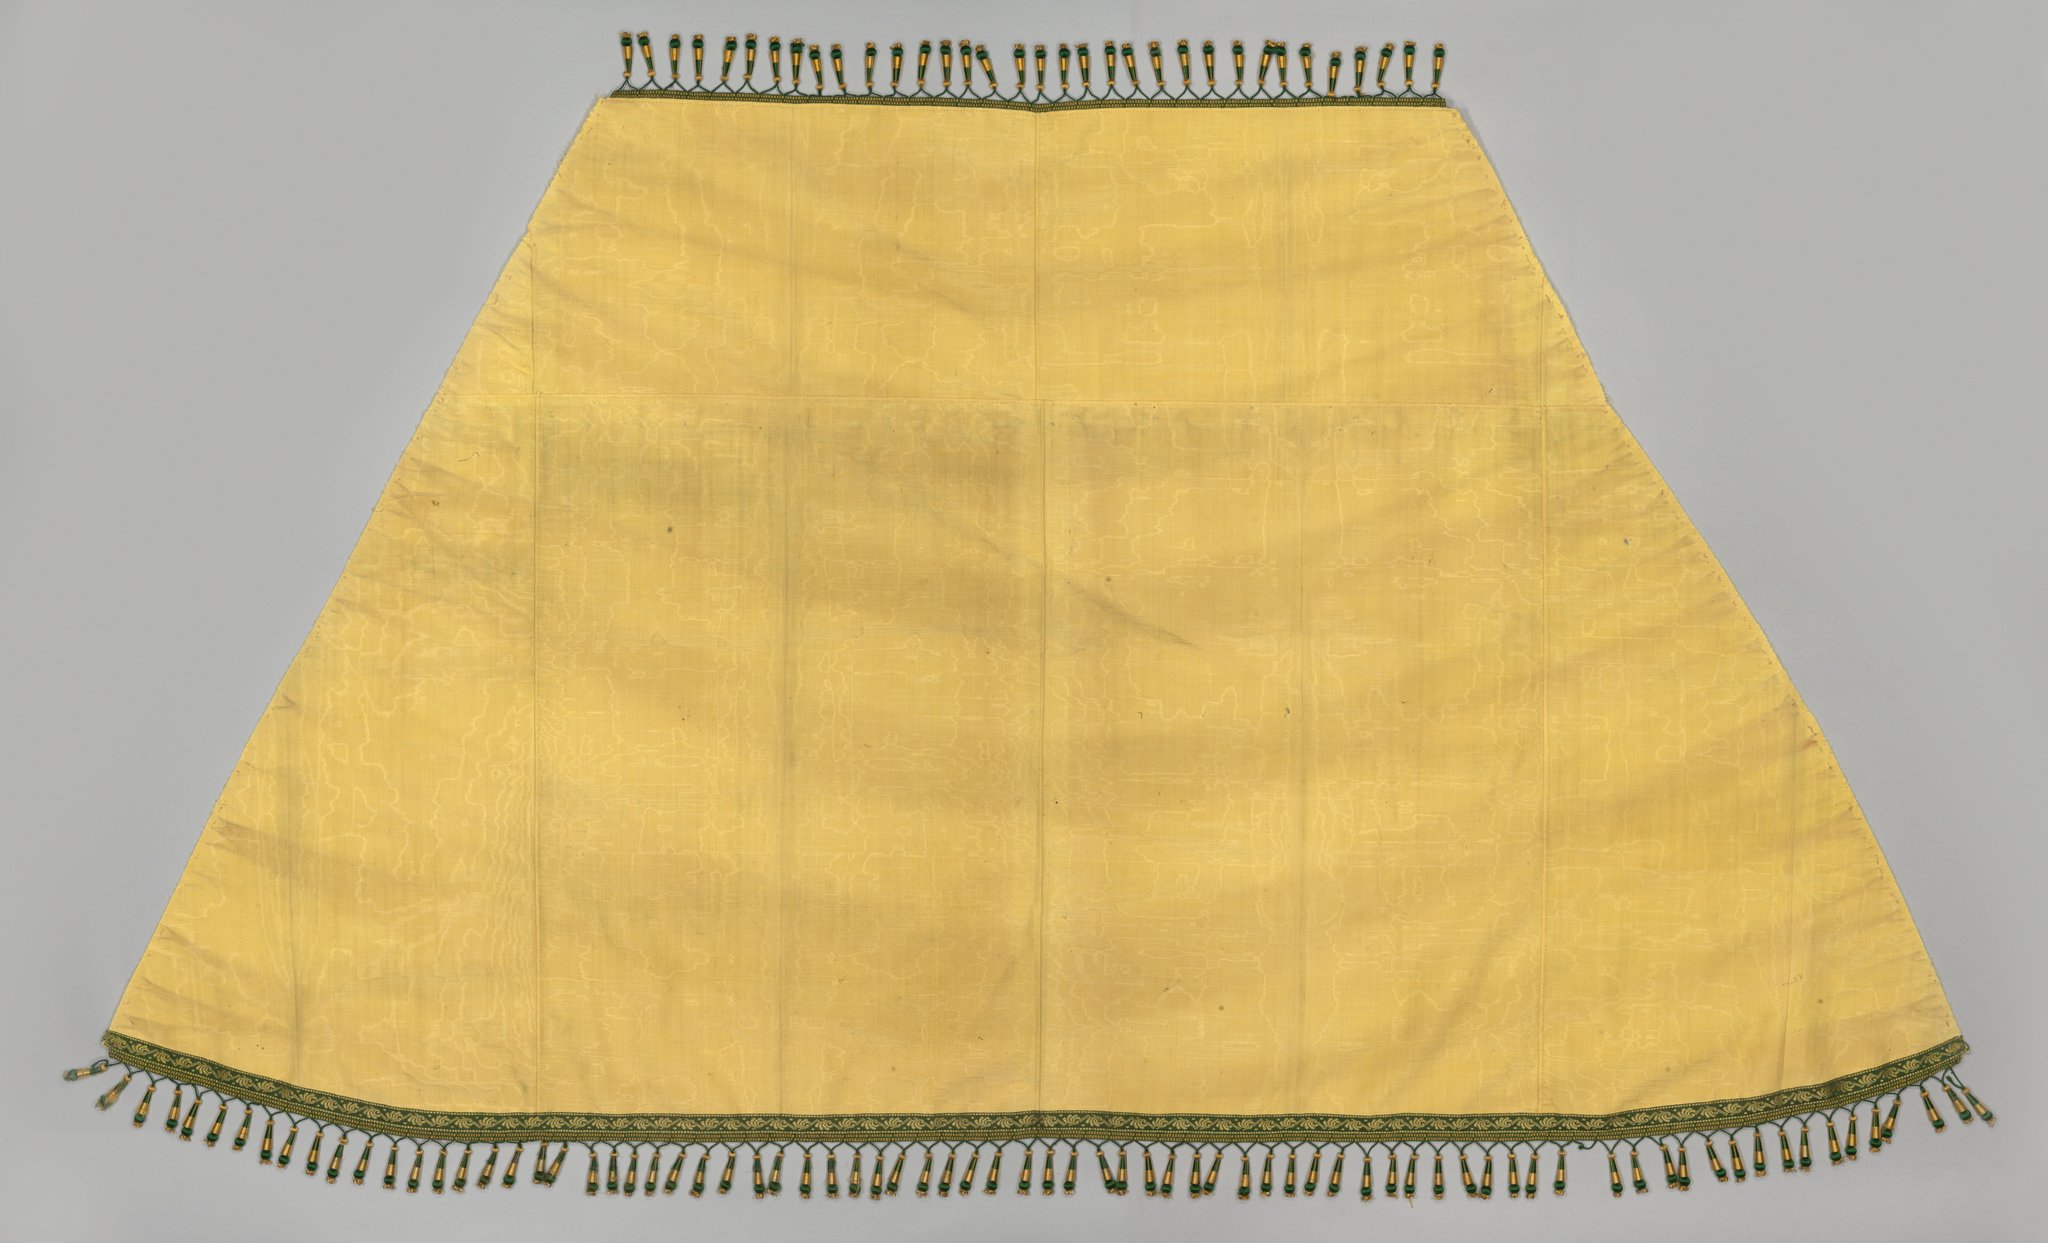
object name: drapery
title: Draperie van een bedgarnituur van gele gewaterde wol met groen passement en afhangende klosjes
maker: Anonymous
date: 1795-1815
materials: silk, wool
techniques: moire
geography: northern netherlands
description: Een draperie voor over een gordijnstok, behorend bij bedgarnituur van gele gewaterde wol, omboord met groen passement met een geel motief en met een groen en geel boordsel met afhangende klosjes die met gele en groene zijde zijn omwonden.